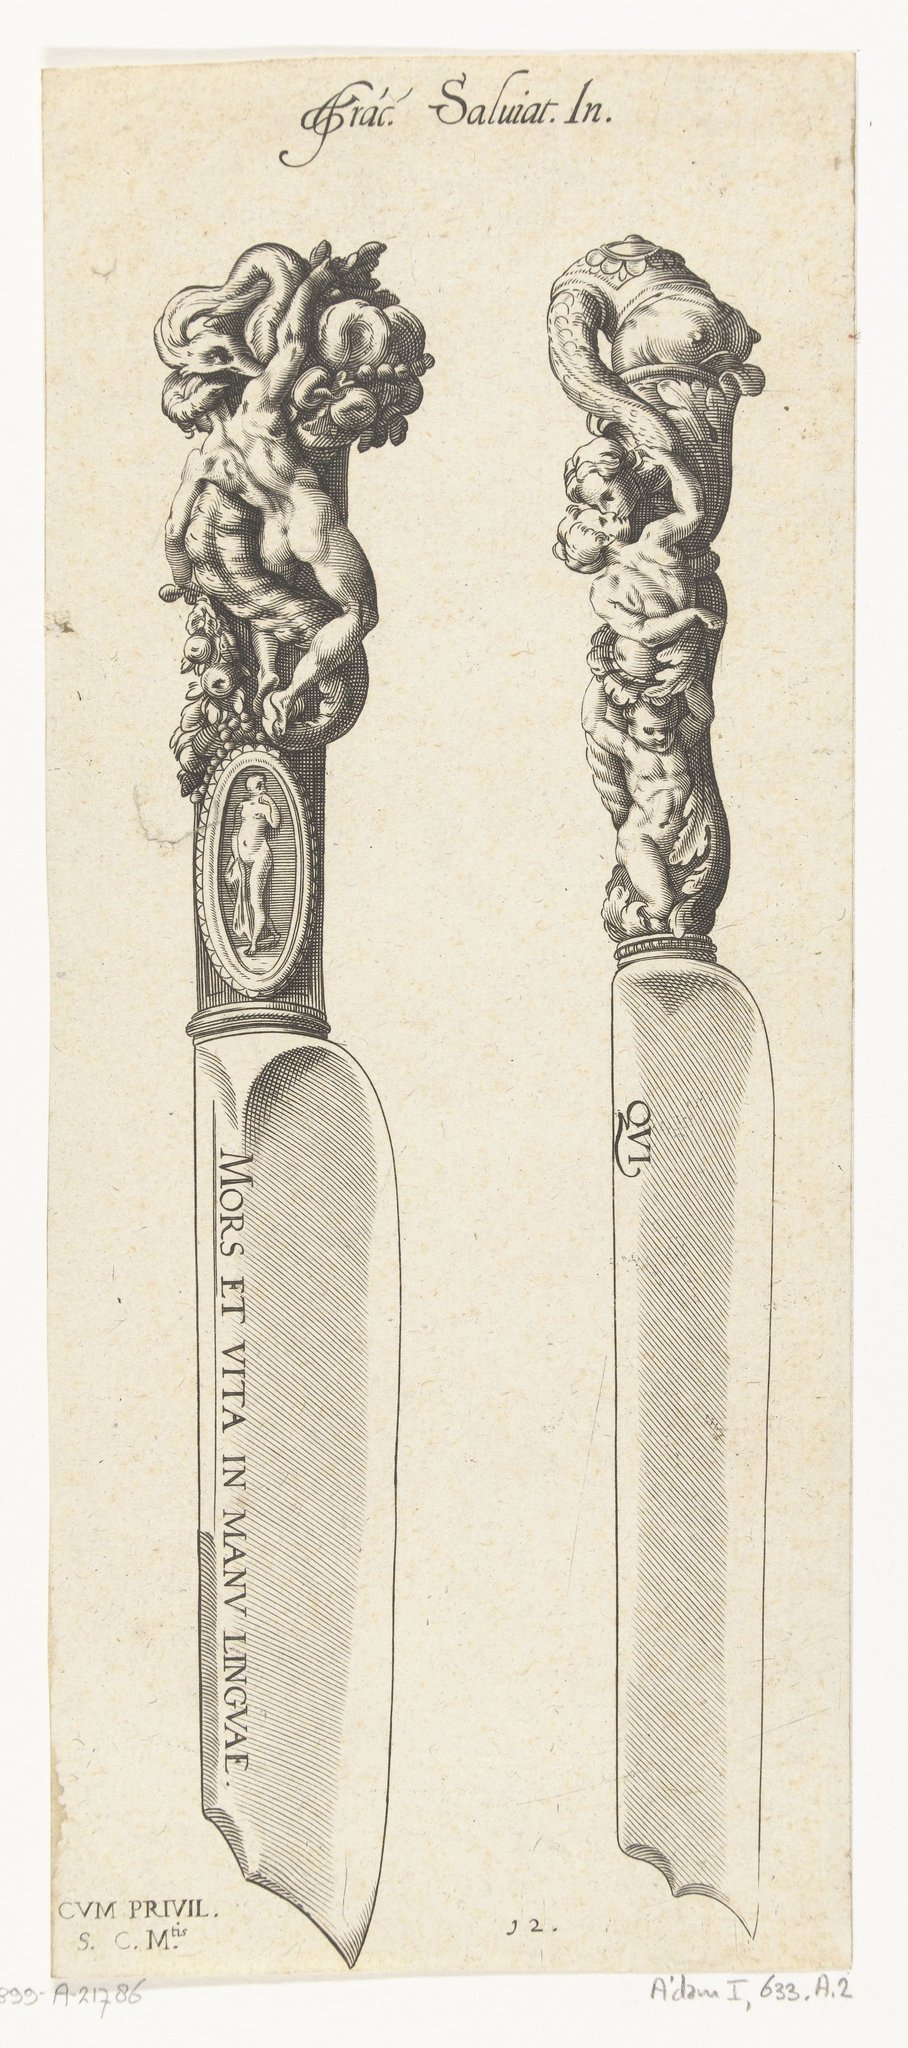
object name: ornament print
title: Messen, telkens twee op één blad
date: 1580-1605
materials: paper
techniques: engraving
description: Tegenzijdige kopie naar prent van Francesco Salviati (RP-P-1899-A-21785). Het heft van het rechter mes is gedecoreerd met een vrouw en een kind. Het mes wordt bekroond door de buste van een vrouwelijk wezen met een lange geschubde hals. Het heft van het linker mes wordt bekroond door een man, op de rug gezien.